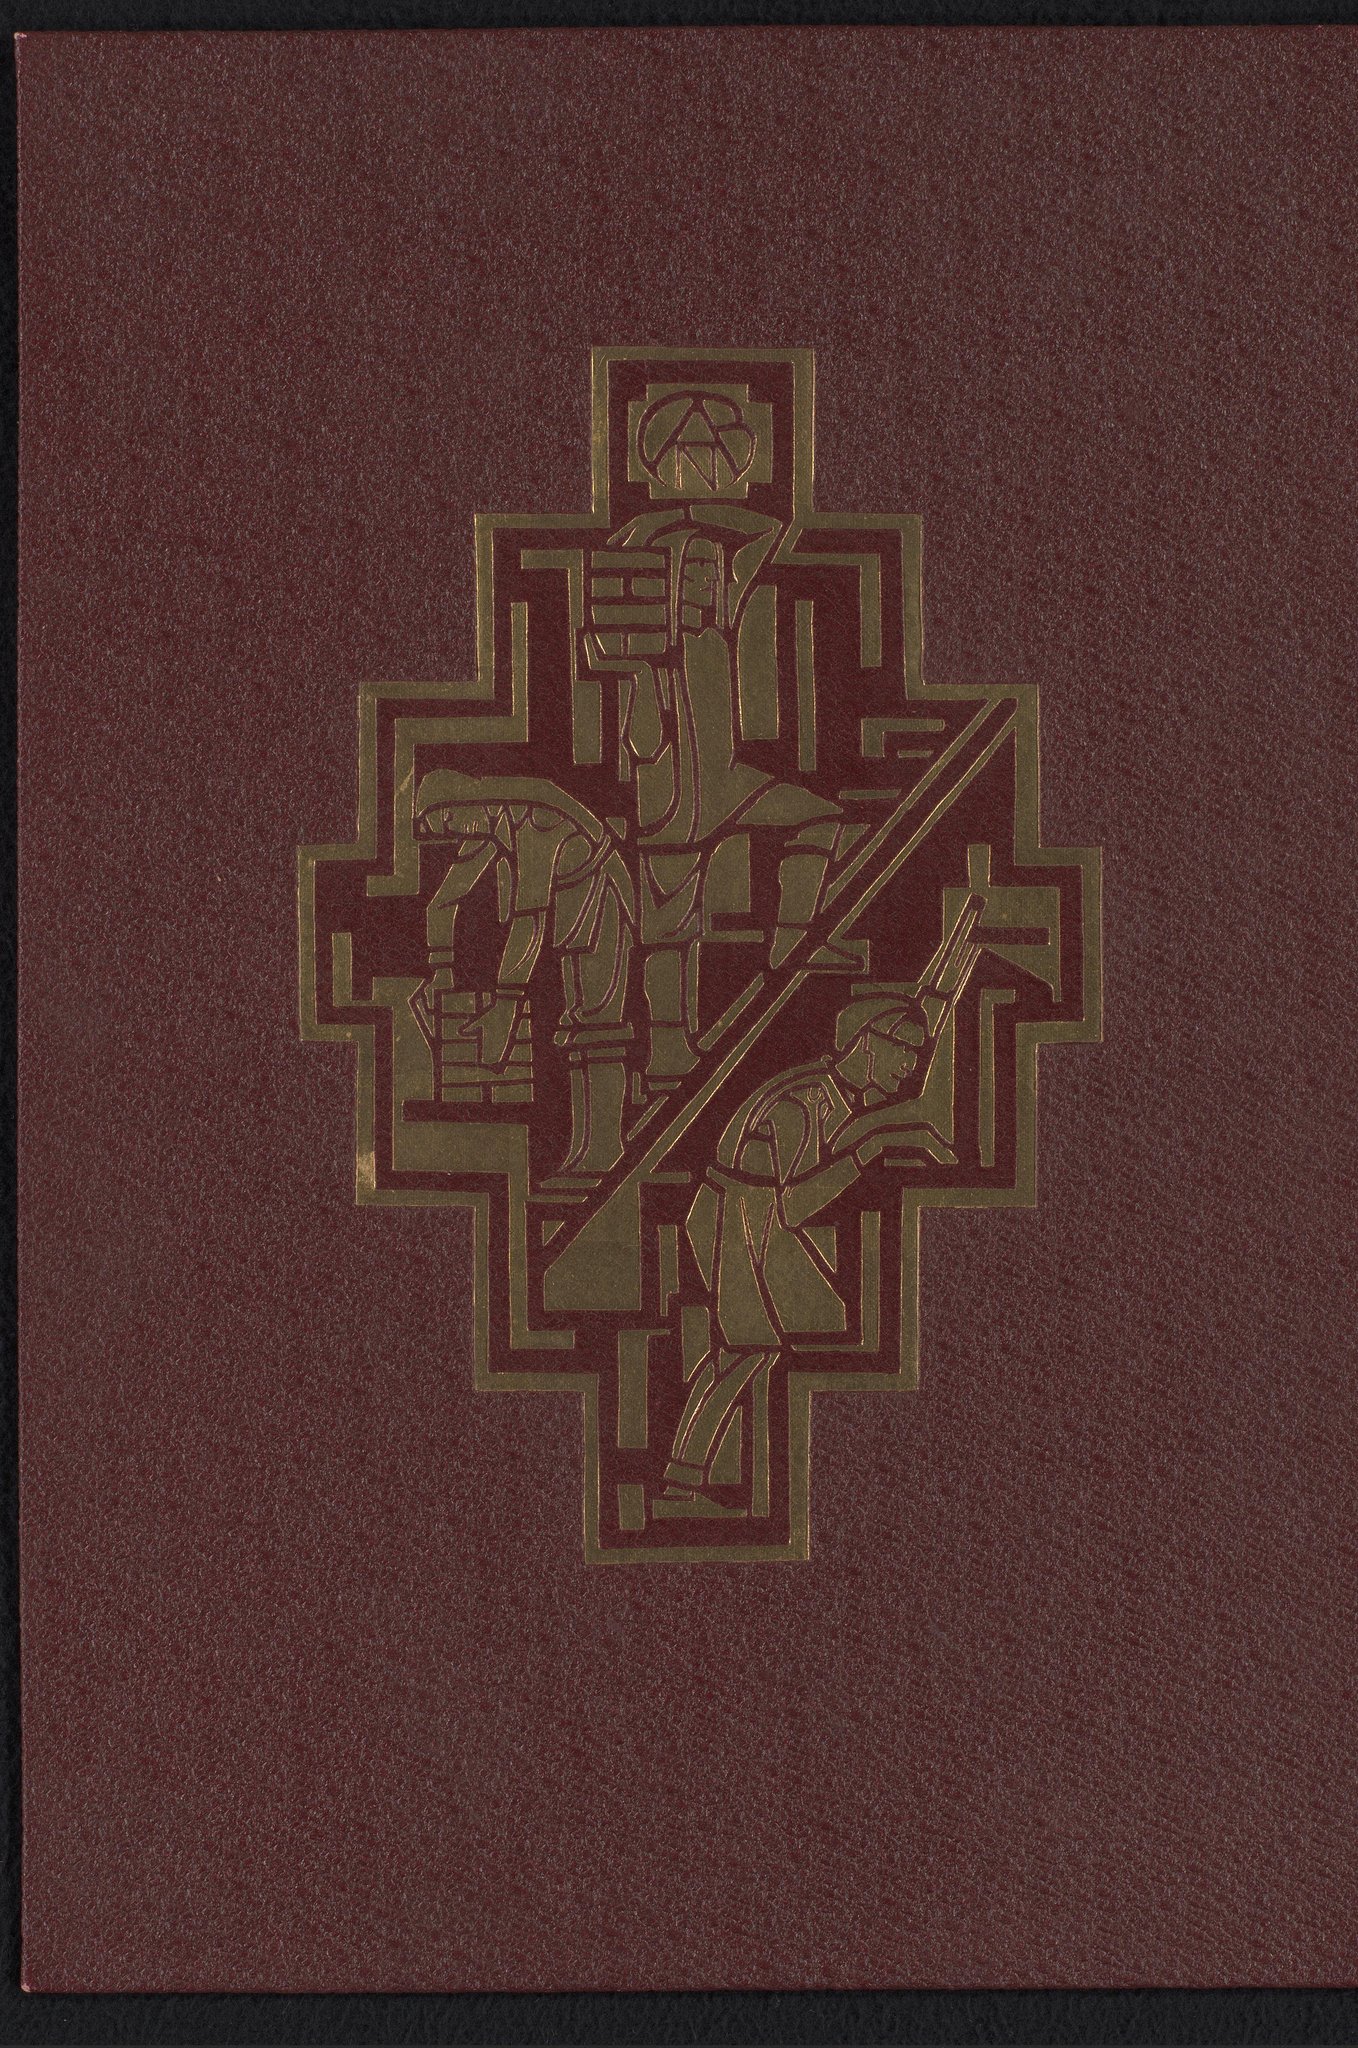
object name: study for binding design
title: Bandontwerp voor het album bij het 25-jarig jubileum van de ANDB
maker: Anonymous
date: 1919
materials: cardboard, linen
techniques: printing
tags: book-cover, binding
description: Dat dit bandontwerp (voor een voorplat) voor een album bij het 25-jarig jubileum zou zijn is gebaseerd op een annotatie op het verso van een tweede exemplaar van dit ontwerp (RP-D-1979-527-E).